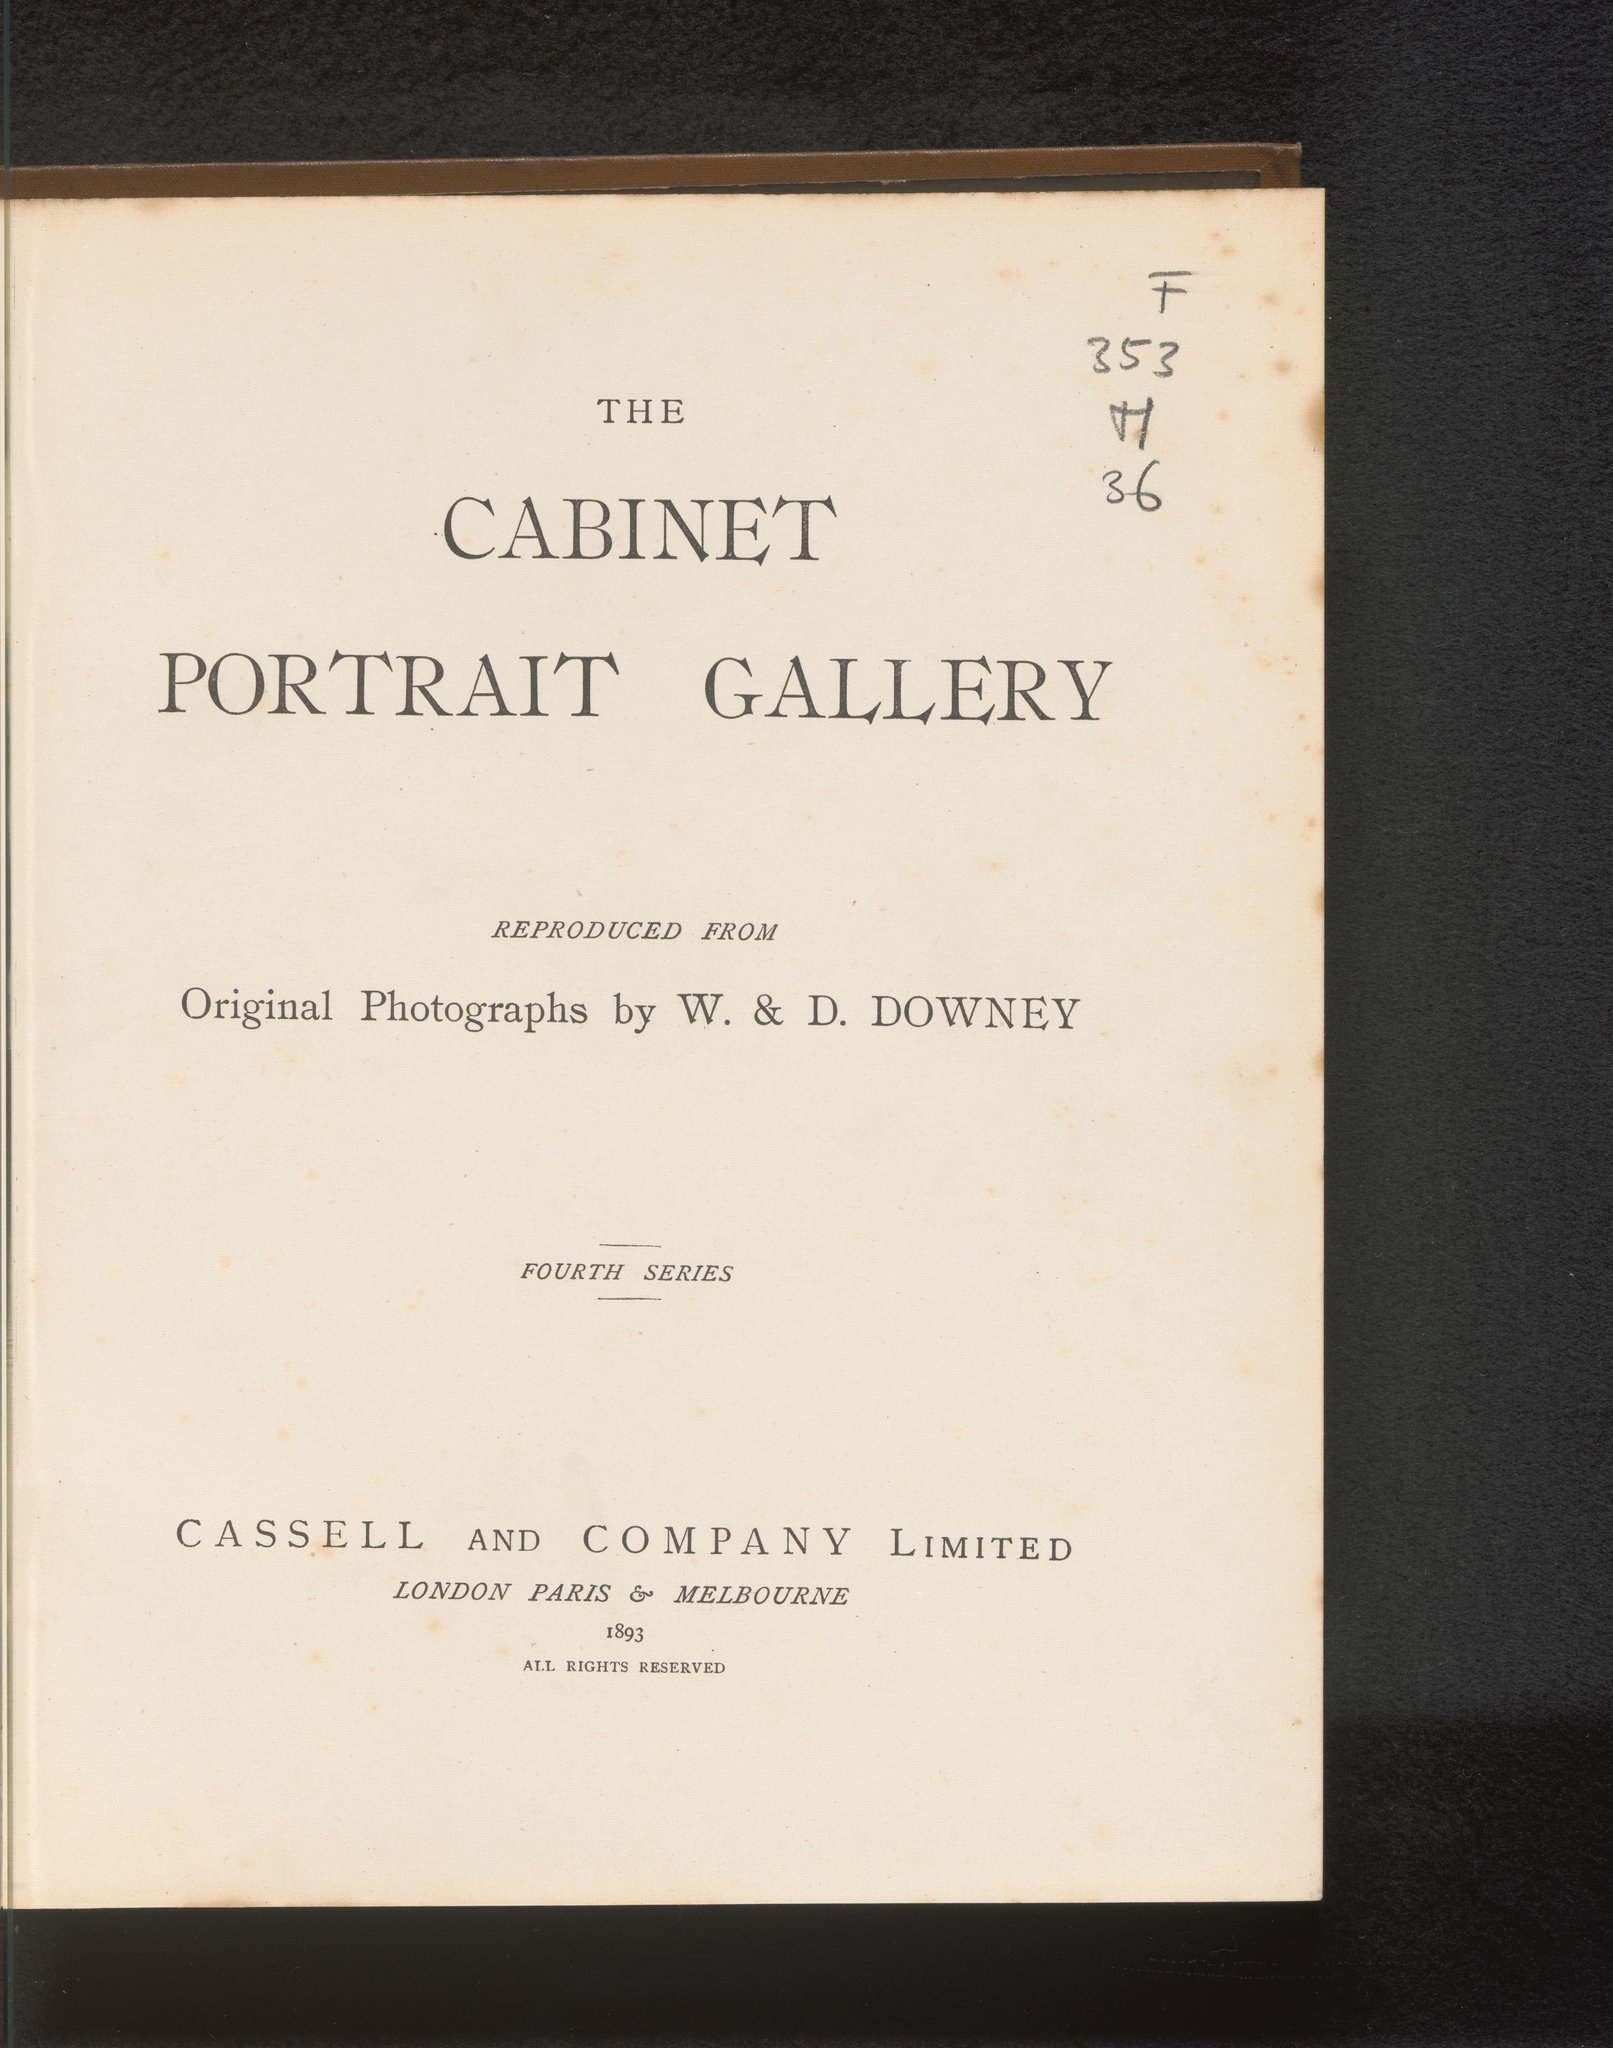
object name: book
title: The cabinet portrait gallery : reproduced from original photographs by W. and D. Downey Fourth Series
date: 1893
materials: linen, paper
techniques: woodburytype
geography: london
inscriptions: name: ‘John Macgregor Leith.’